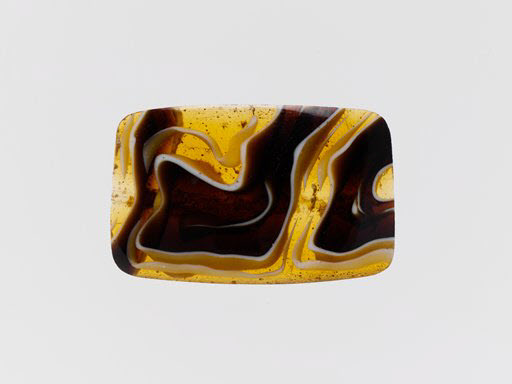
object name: fragment, mosaic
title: Mosaic glass fragment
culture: roman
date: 34 BCE-33 CE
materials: glass